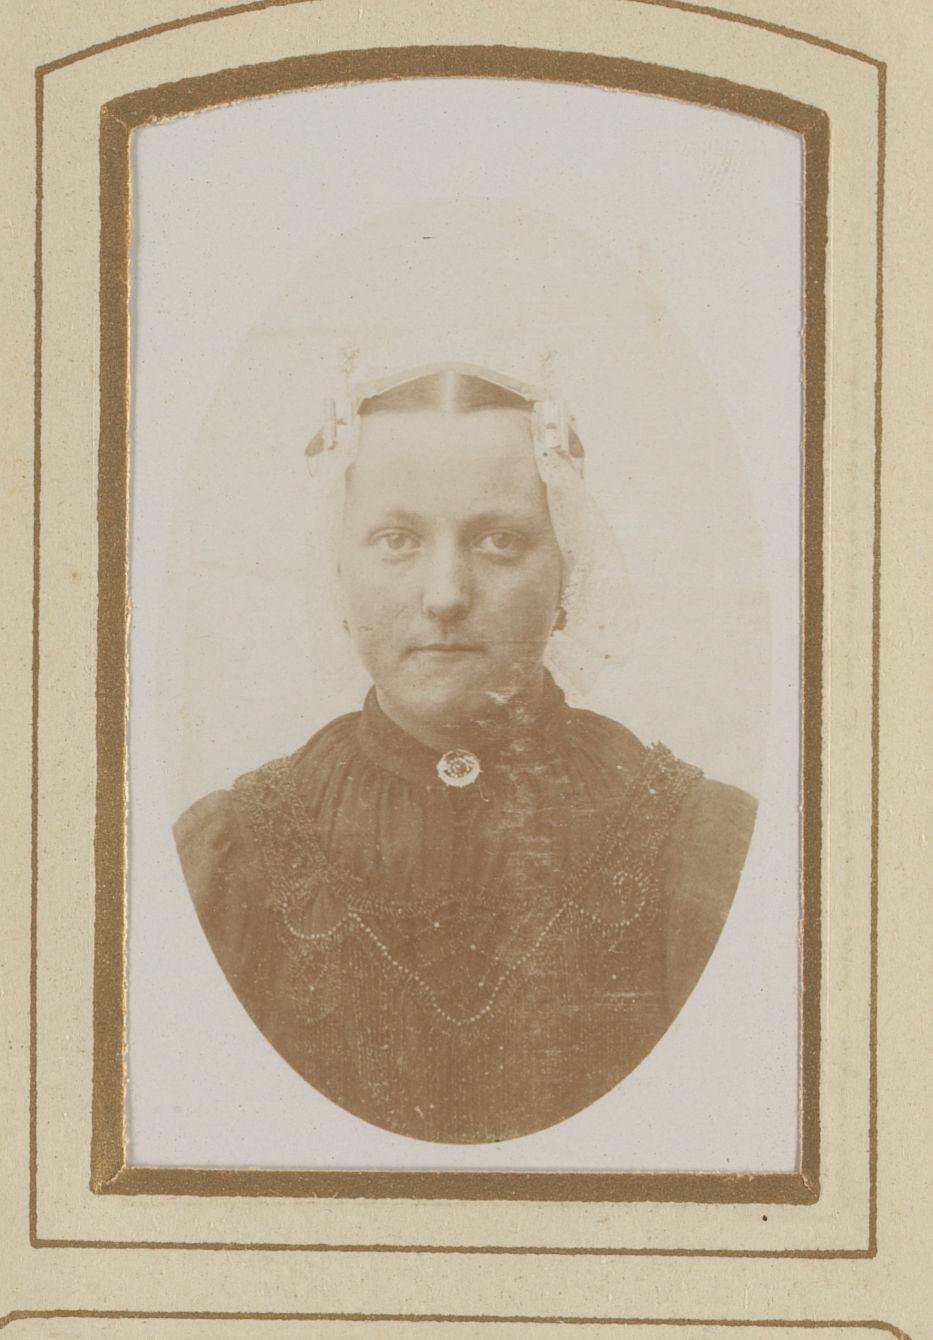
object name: carte de visite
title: Portret van een vrouw met witte klederdrachtmuts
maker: Anonymous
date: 1880-1920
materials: cardboard, photographic support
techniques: collodion silver print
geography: netherlands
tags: historical persons - bb - woman, head-gear: cap, folk costume, regional costume